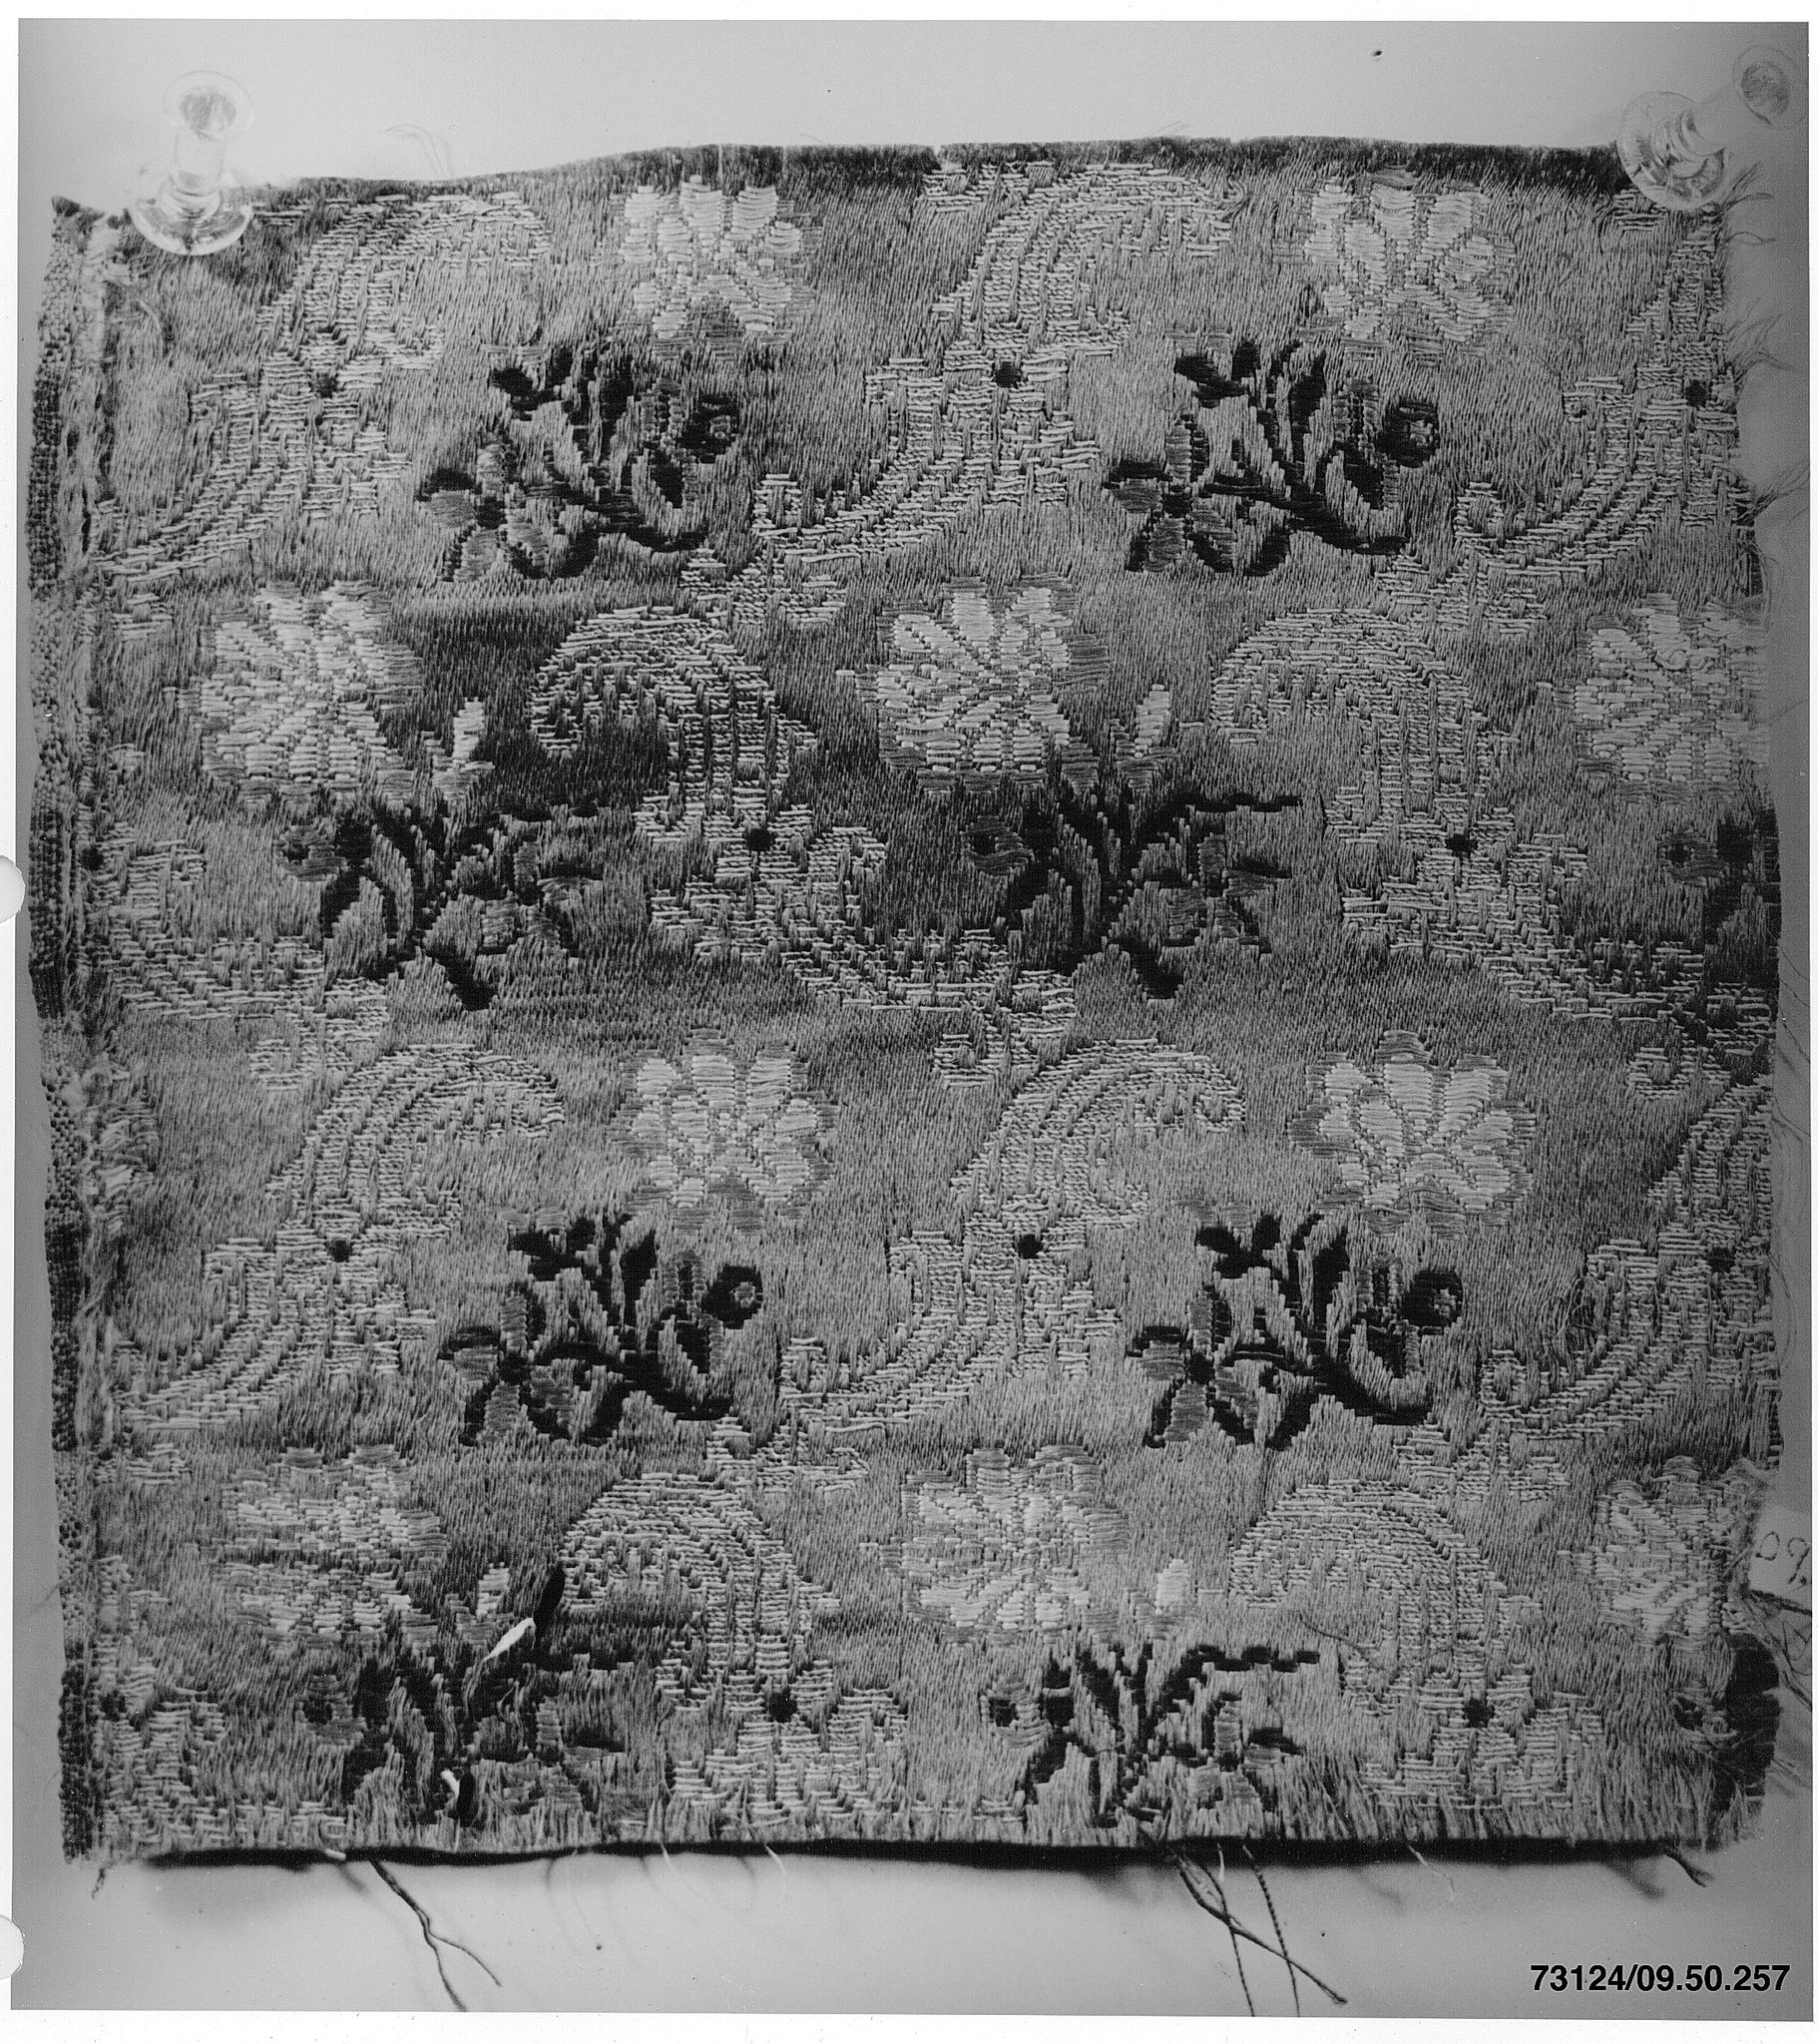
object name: fragment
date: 1750-1760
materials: metal thread, silk